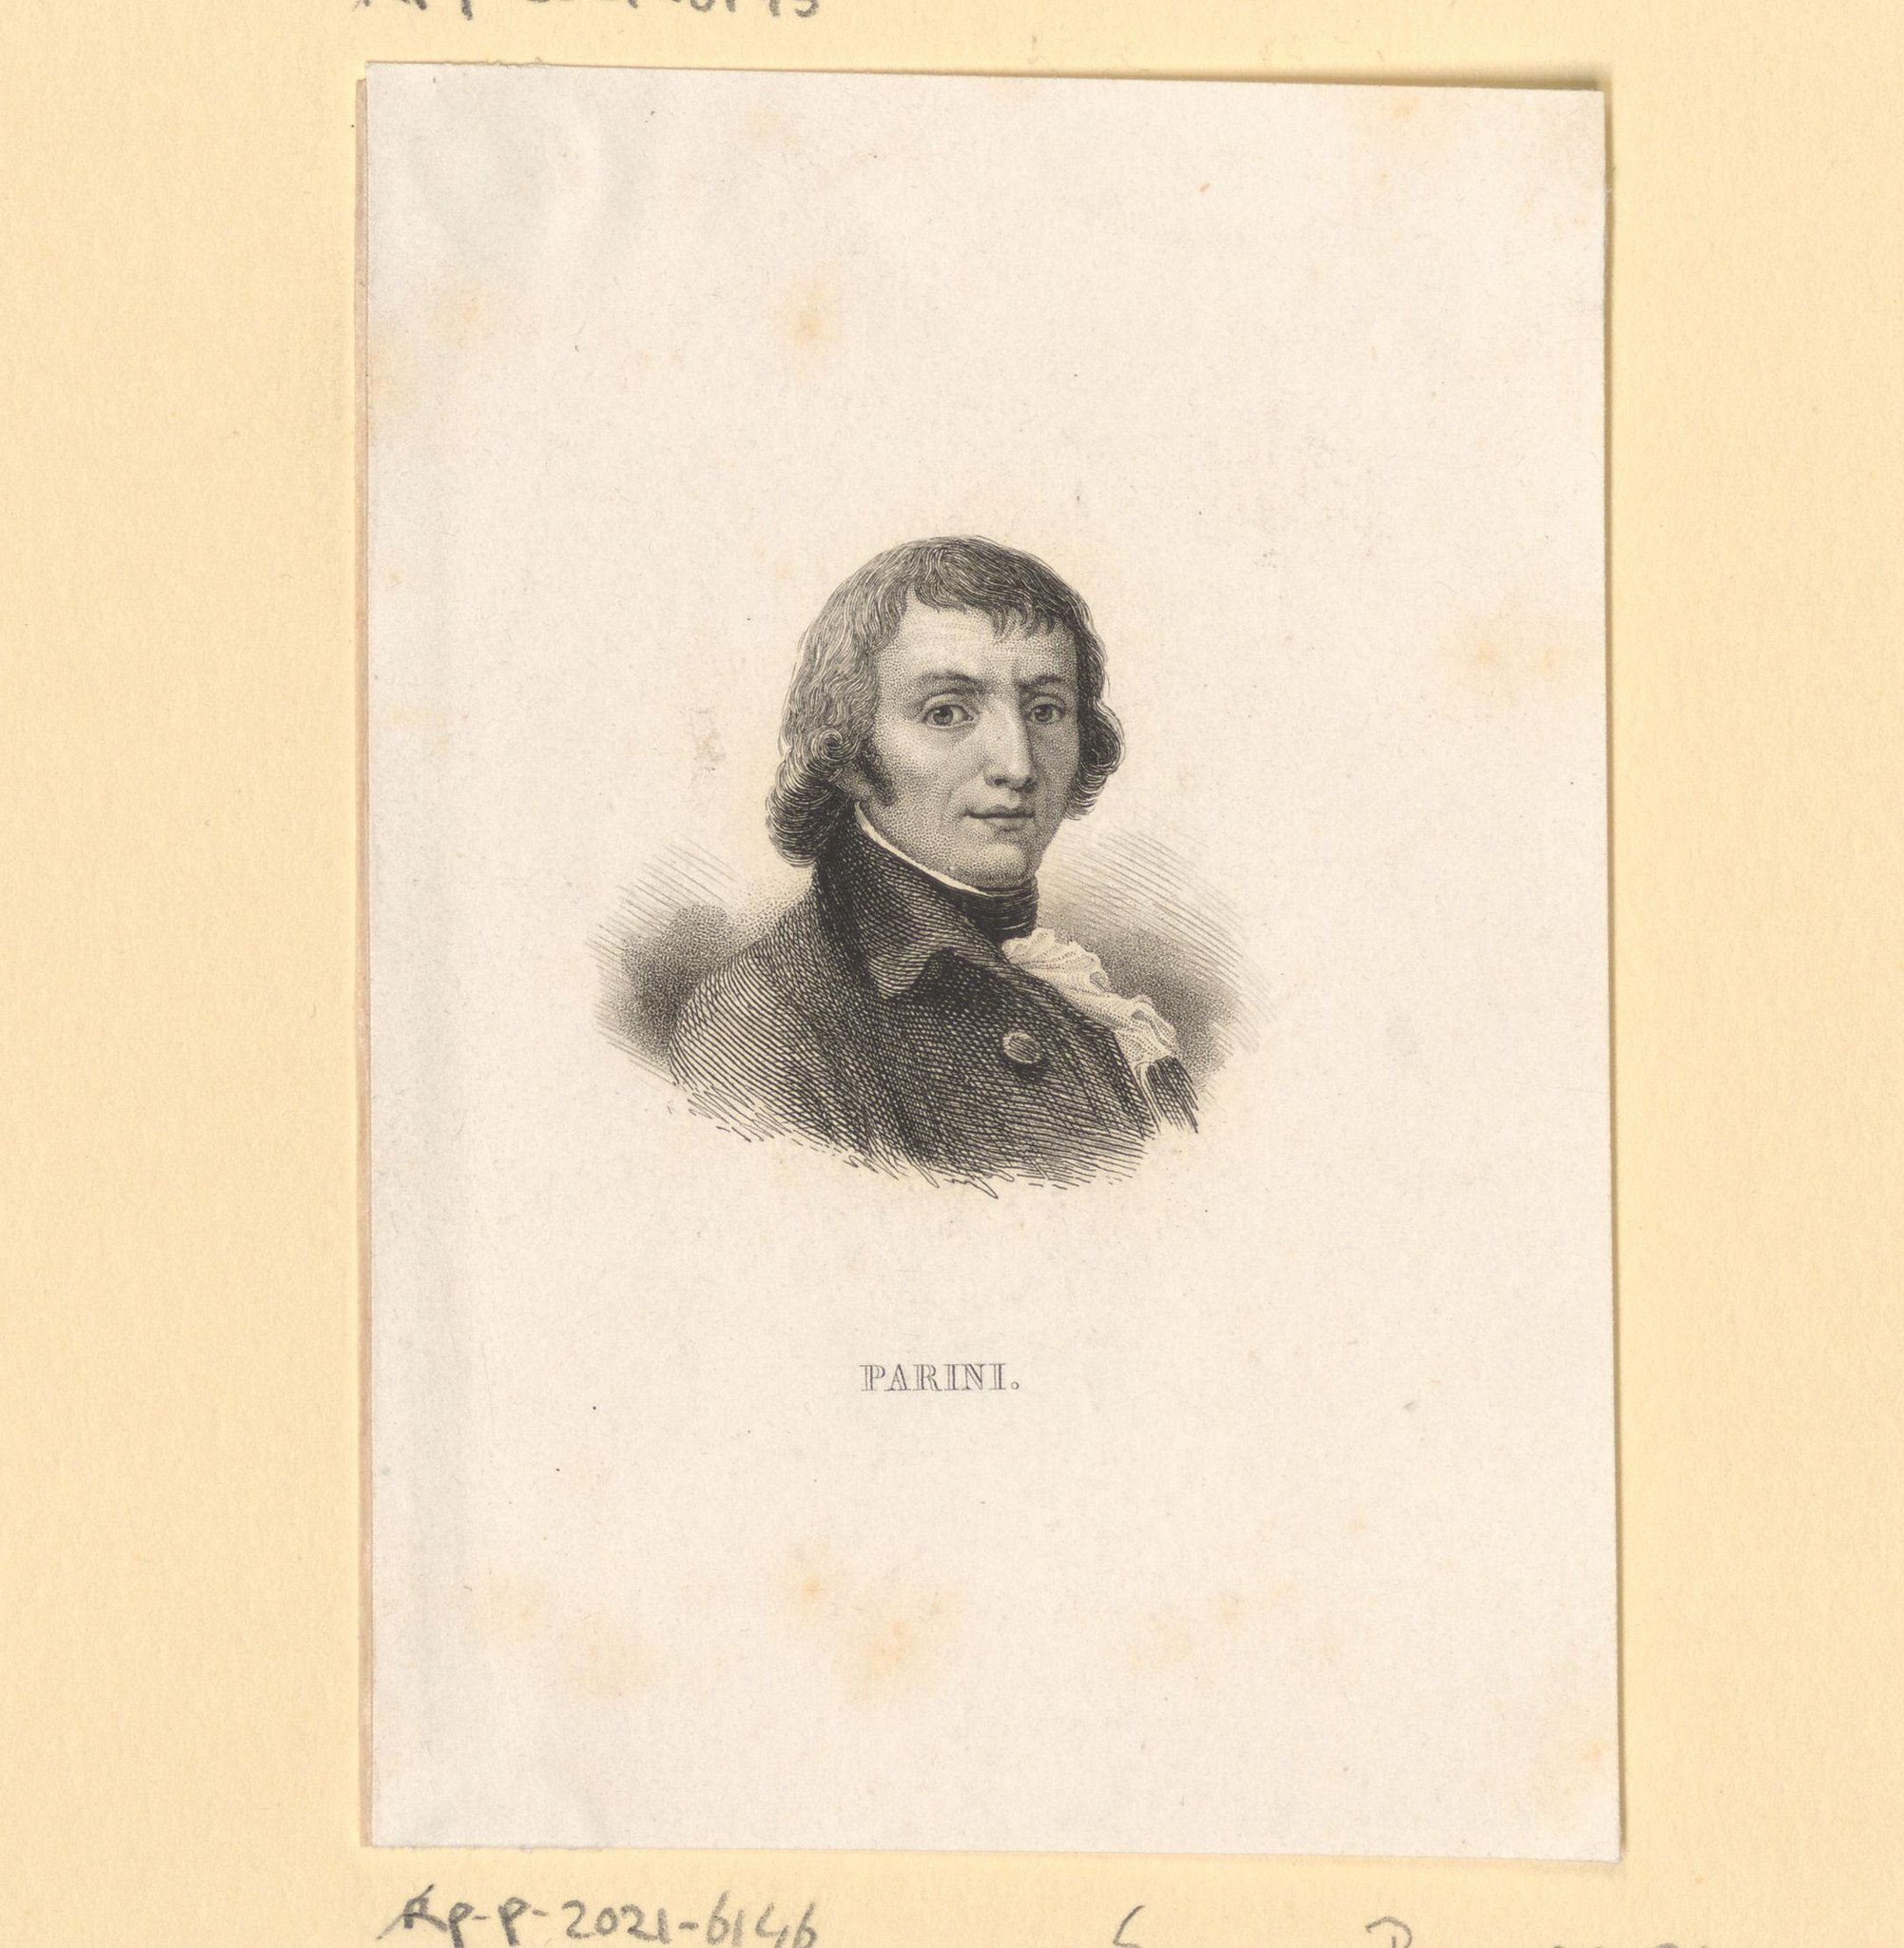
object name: print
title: Portret van Giuseppe Parini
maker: Anonymous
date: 1750-1849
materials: paper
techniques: engraving, roulette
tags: adult man, historical persons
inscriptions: collector's mark: Lugt 2228